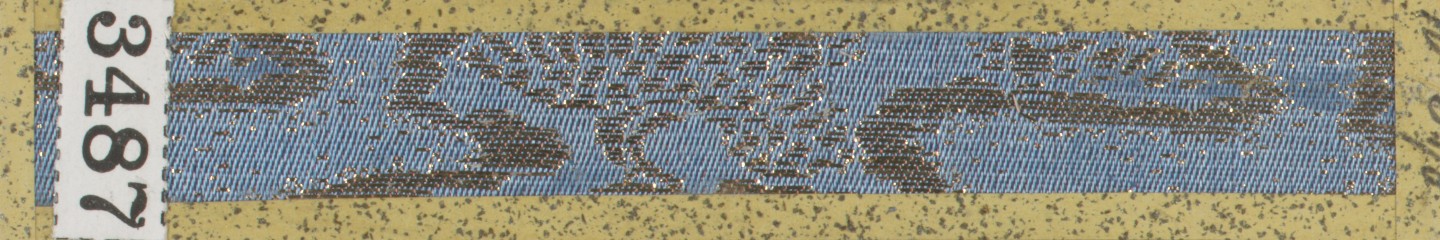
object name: sample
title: Textile Sample from Sample Book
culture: japanese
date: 1801-1900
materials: silk